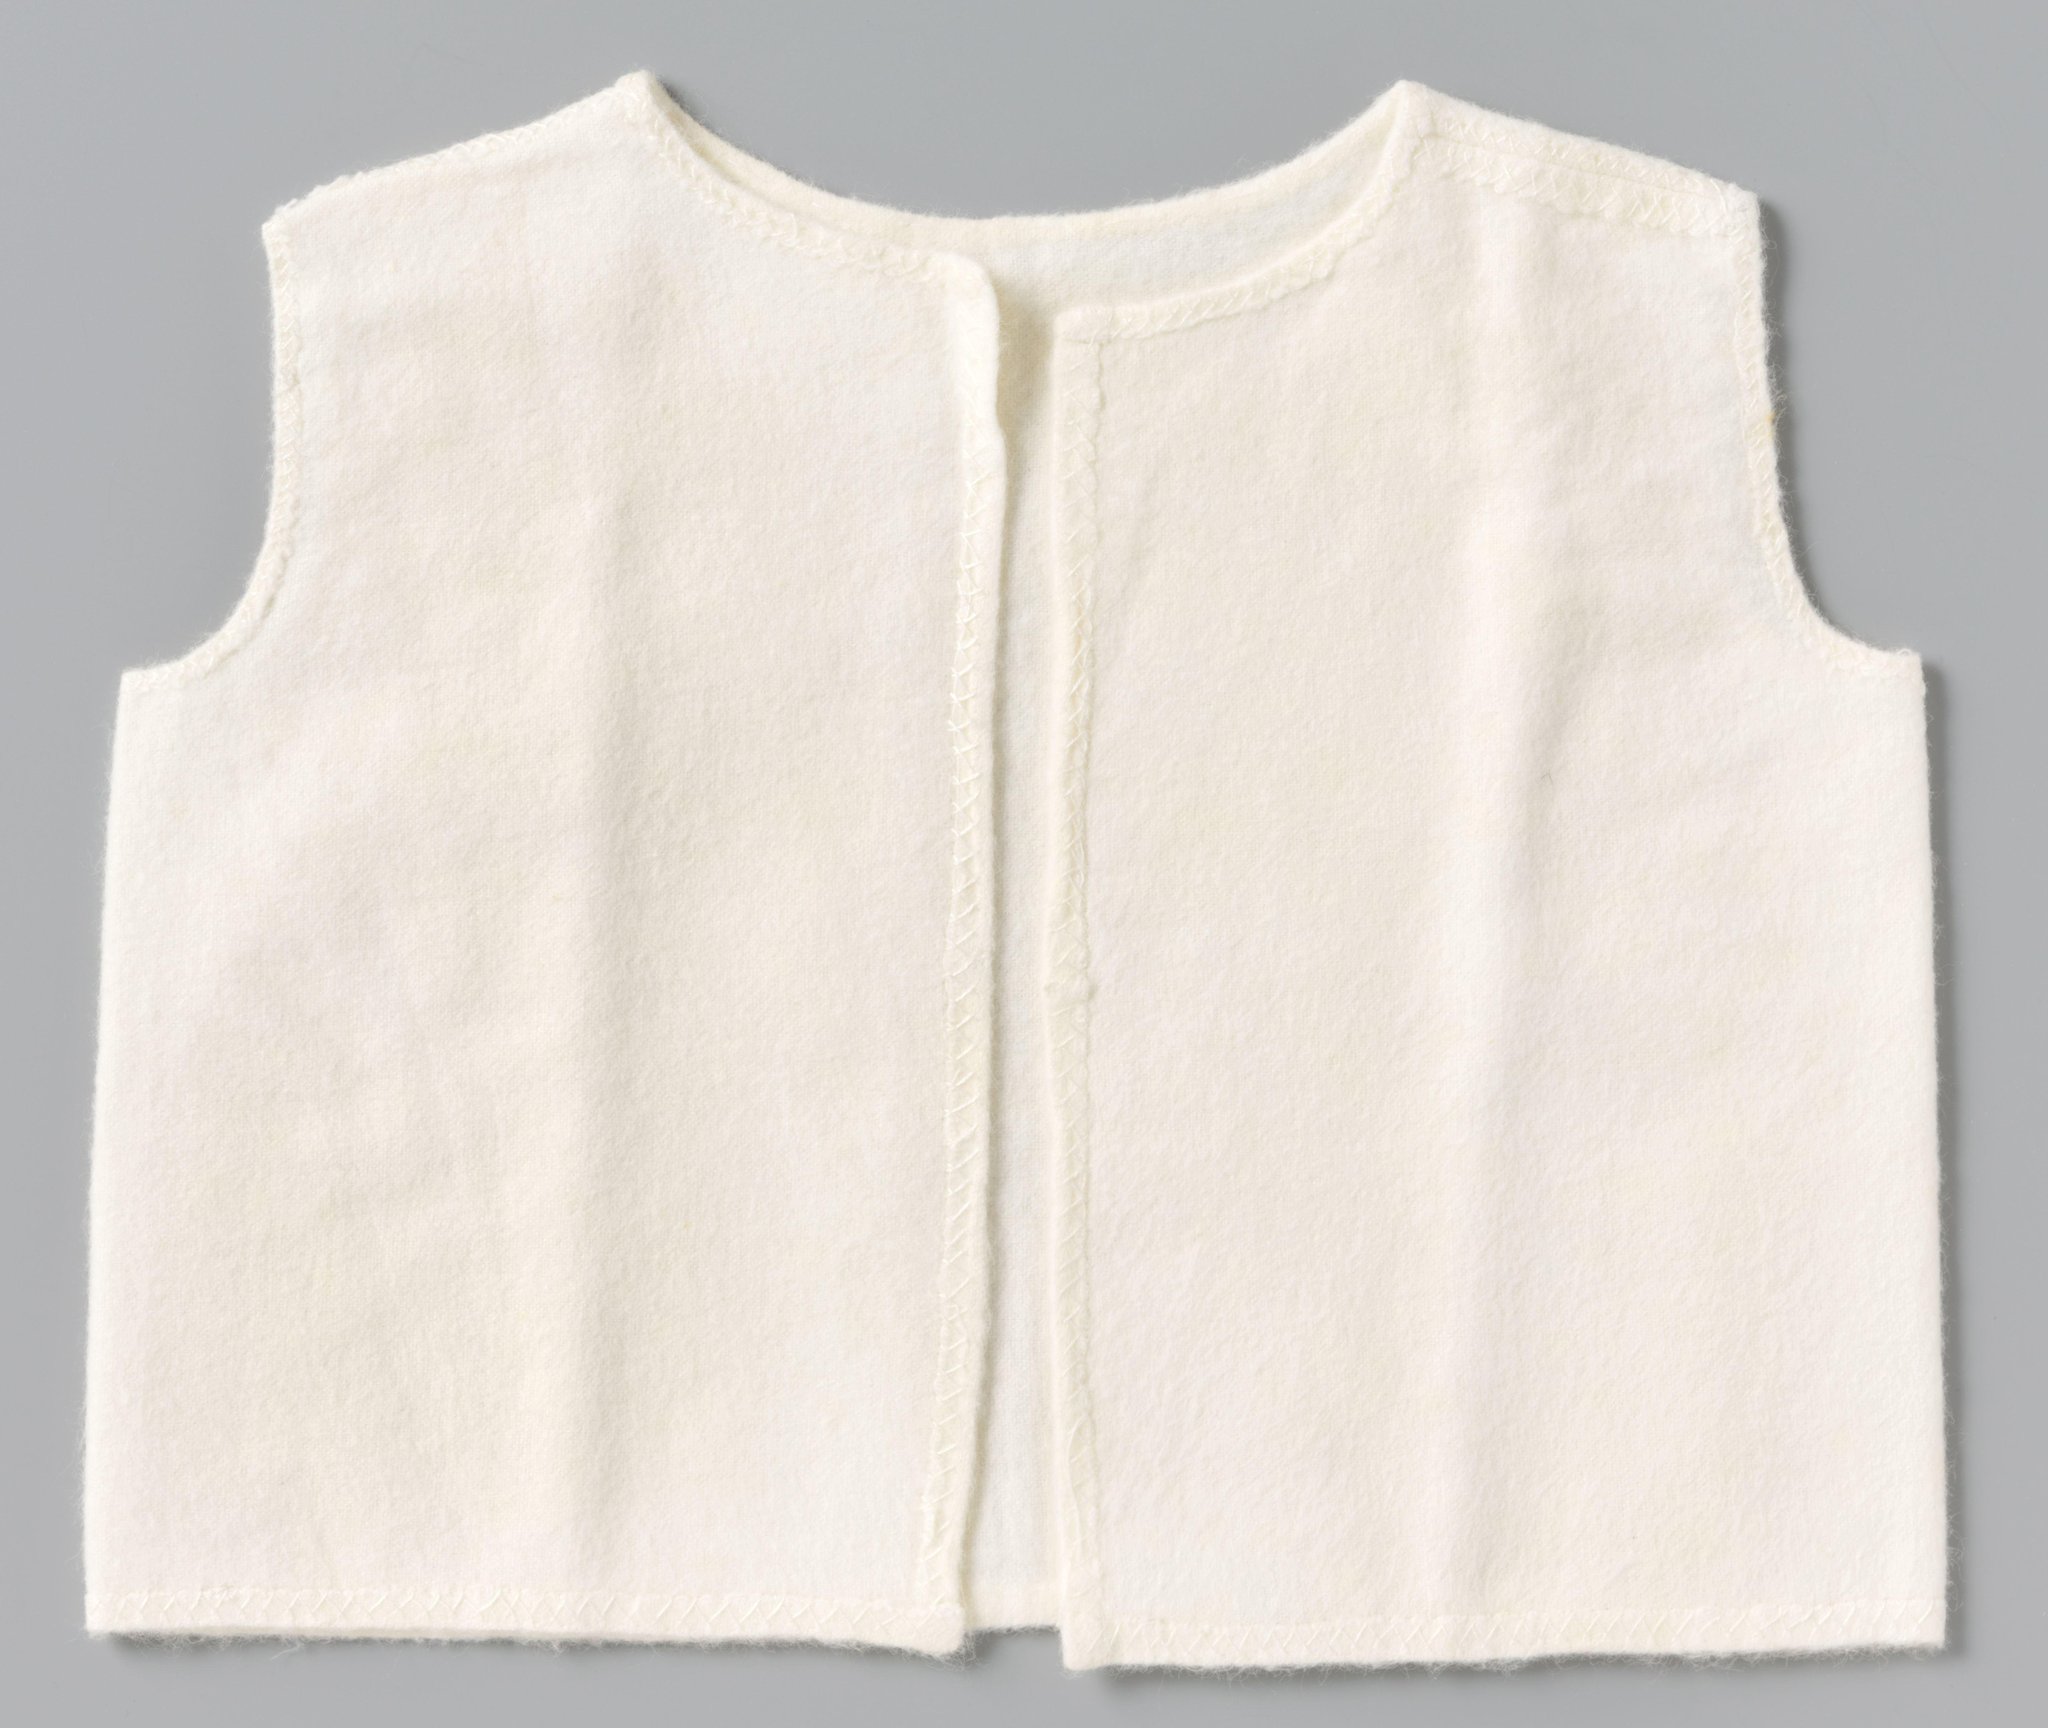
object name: childrenswear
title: Babyhemd van witte flanel met een rand in witte flanelsteek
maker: Anonymous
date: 1917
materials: textile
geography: amsterdam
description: Babyhemd van witte flanel met een rand in witte flanelsteek. Zie tevens: BK-1977-218-a. Comeniusschool.